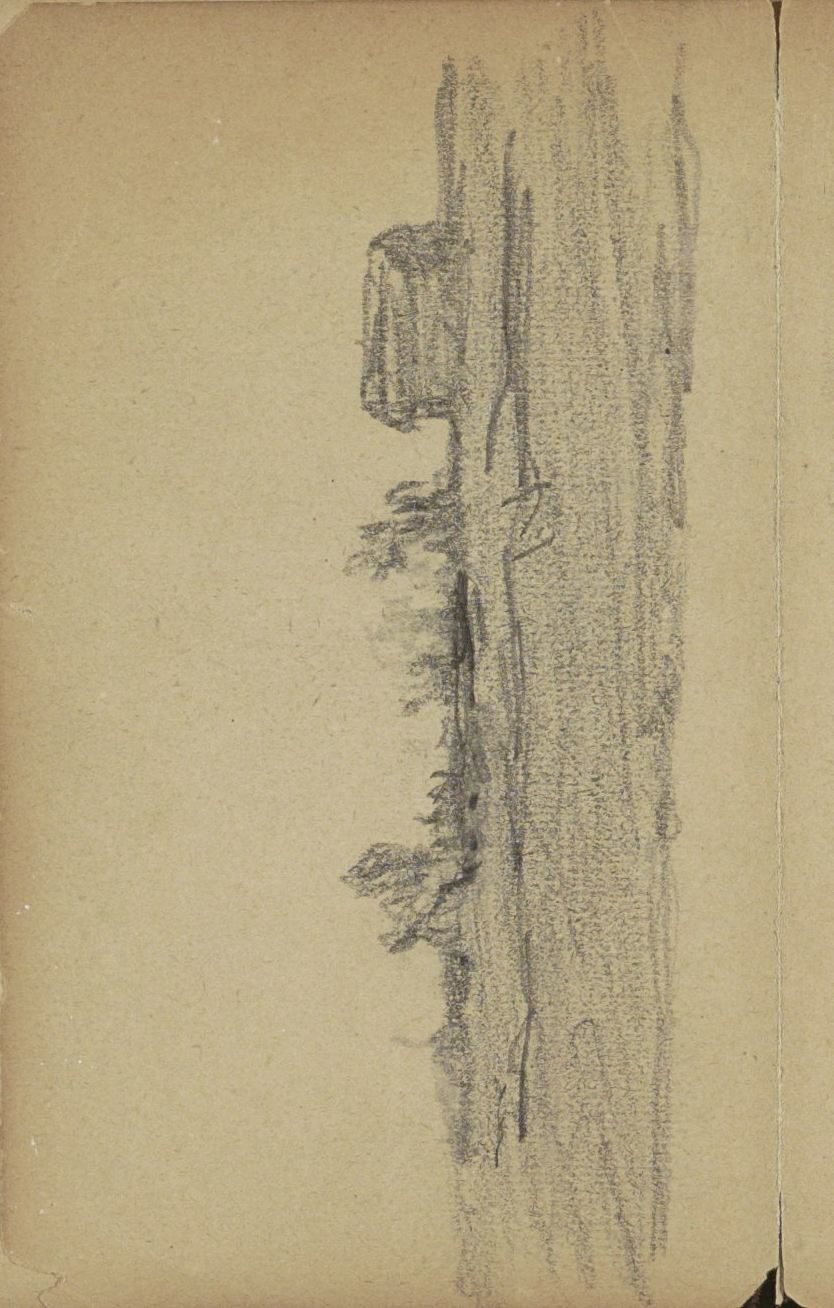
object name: sketchbook leaf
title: Huis in een landschap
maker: johan hendrik weissenbruch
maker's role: draughtsman, painter, print maker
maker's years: 1824-1903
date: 1834-1903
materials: paper, pencil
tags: farm or solitary house in landscape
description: Blad 22 verso uit een schetsboek met 32 bladen.